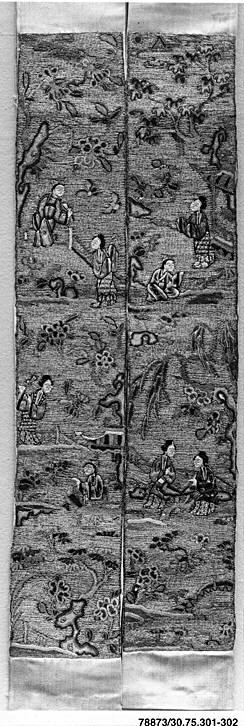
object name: sleeve band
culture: chinese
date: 1801-1900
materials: metal thread, silk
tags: flowers,trees